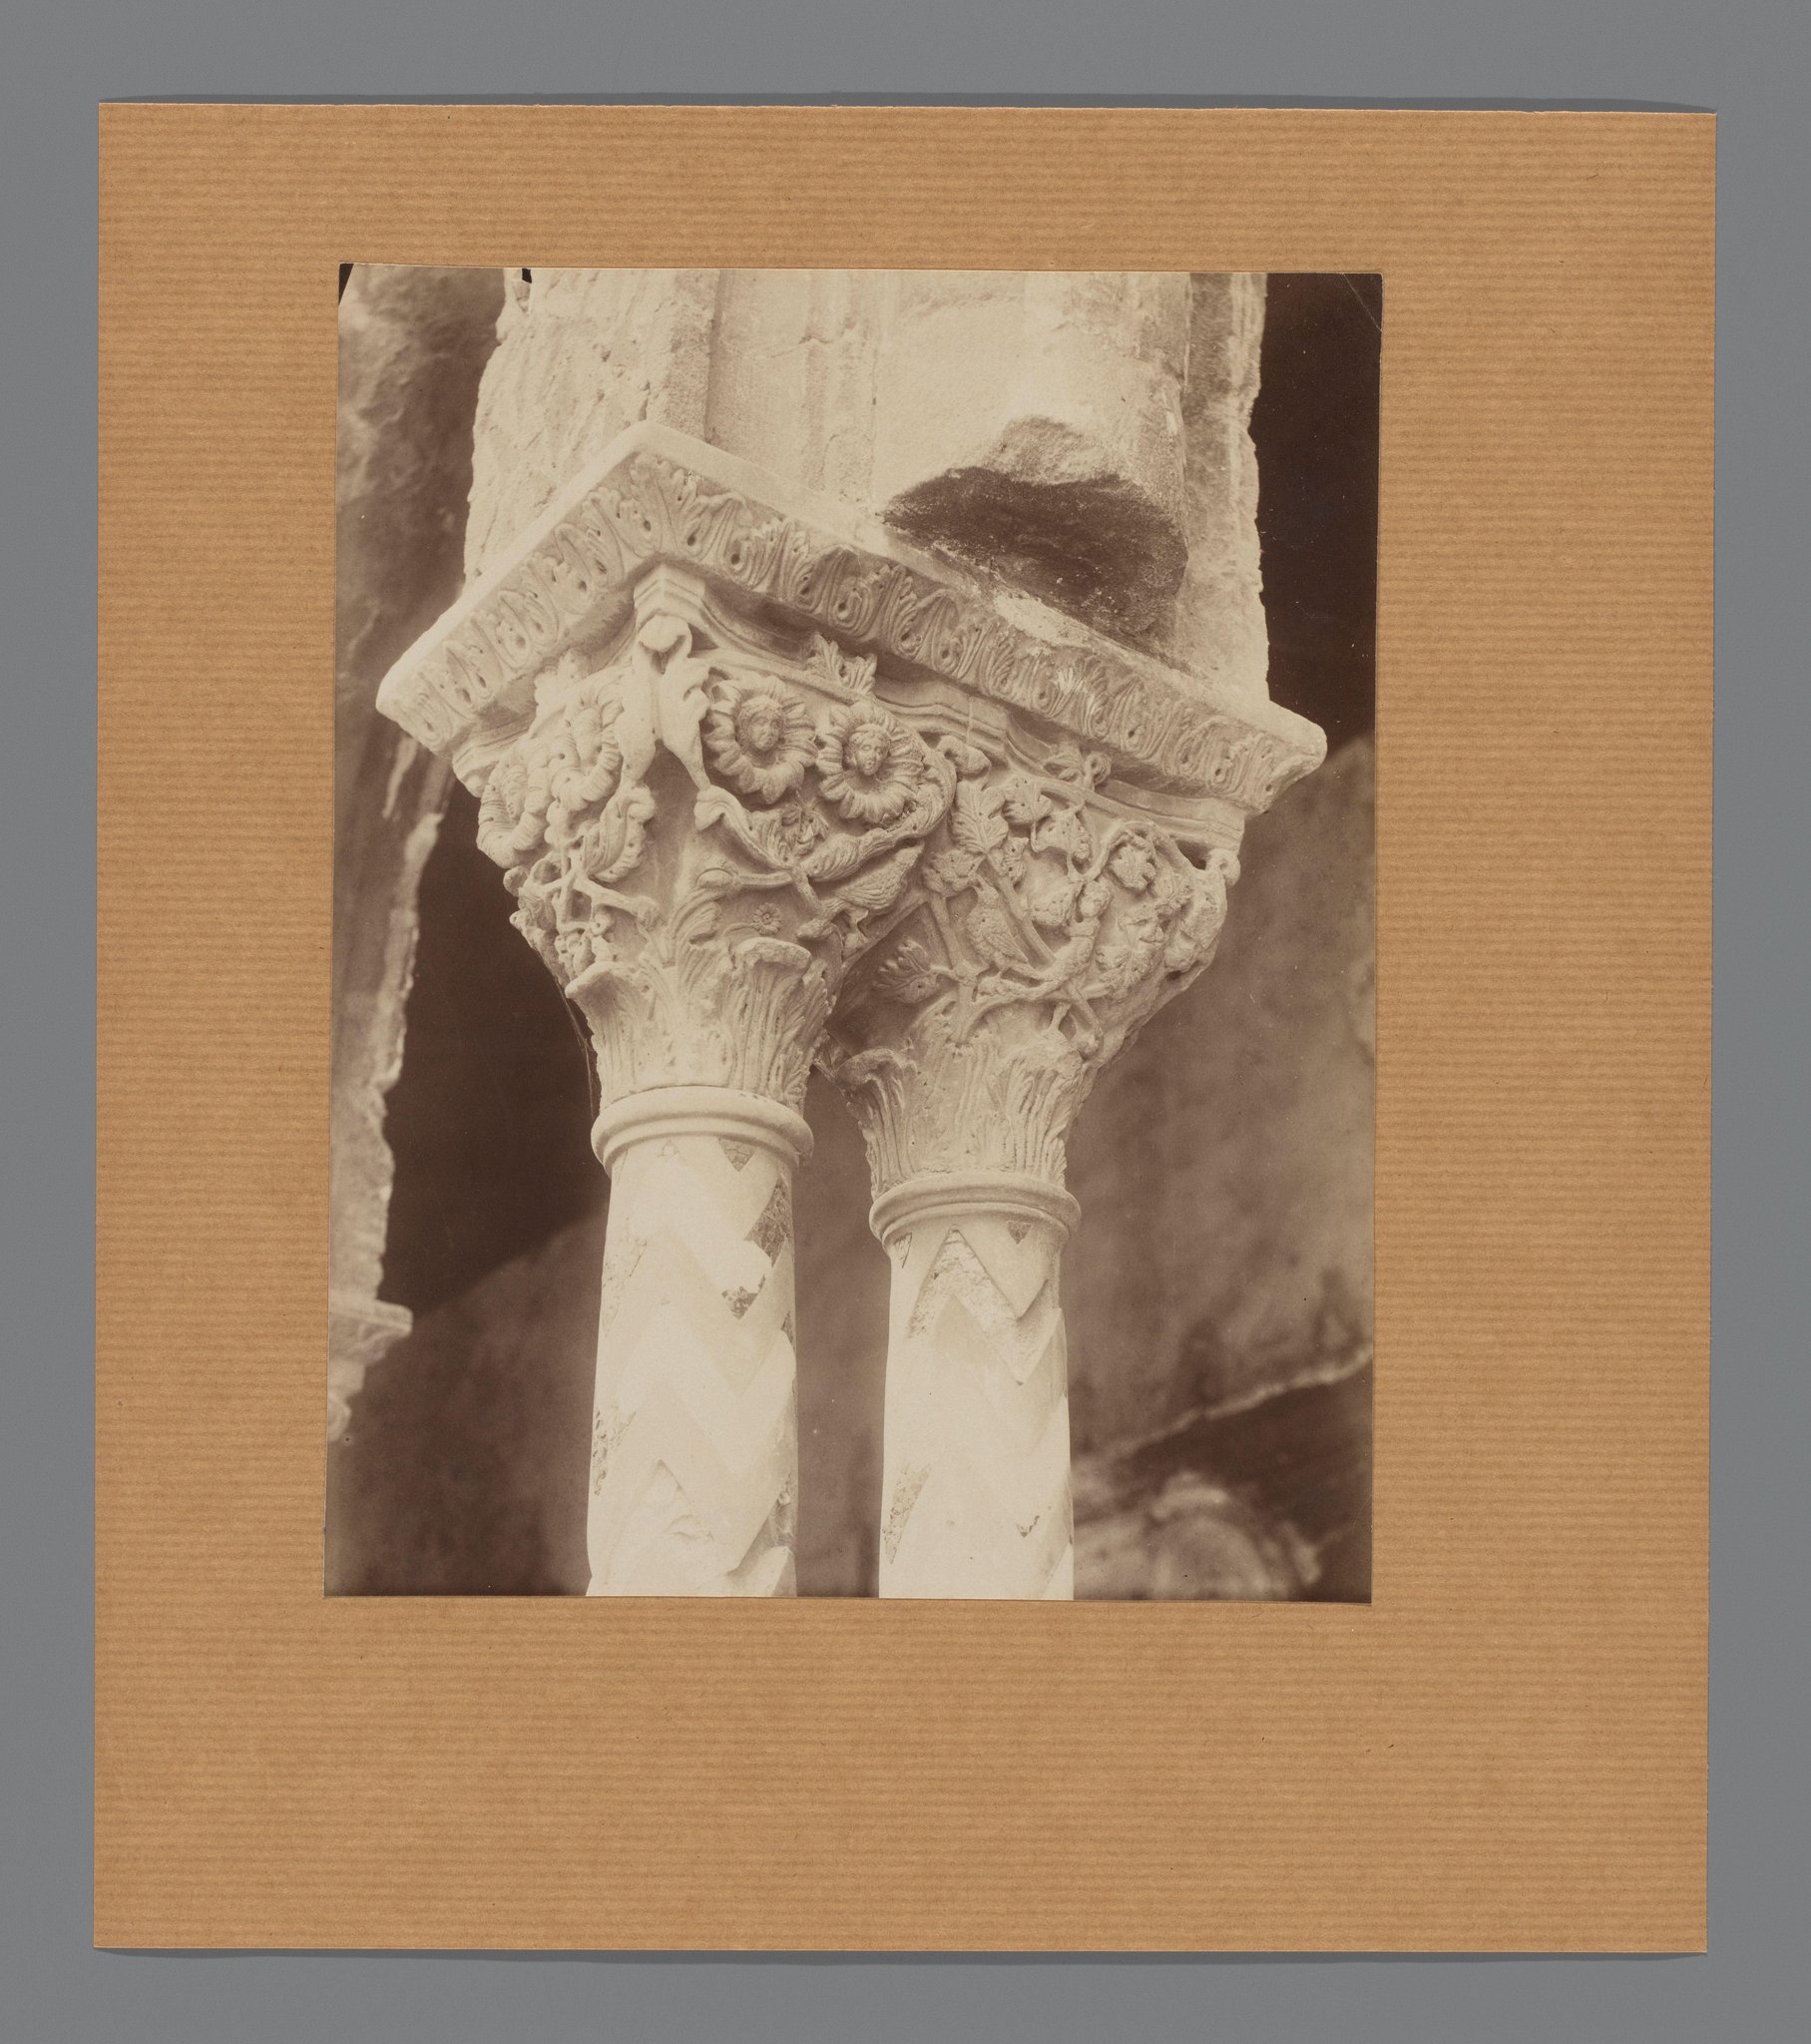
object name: photograph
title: Italië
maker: Anonymous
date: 1880-1910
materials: photographic support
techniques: albumen print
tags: italy